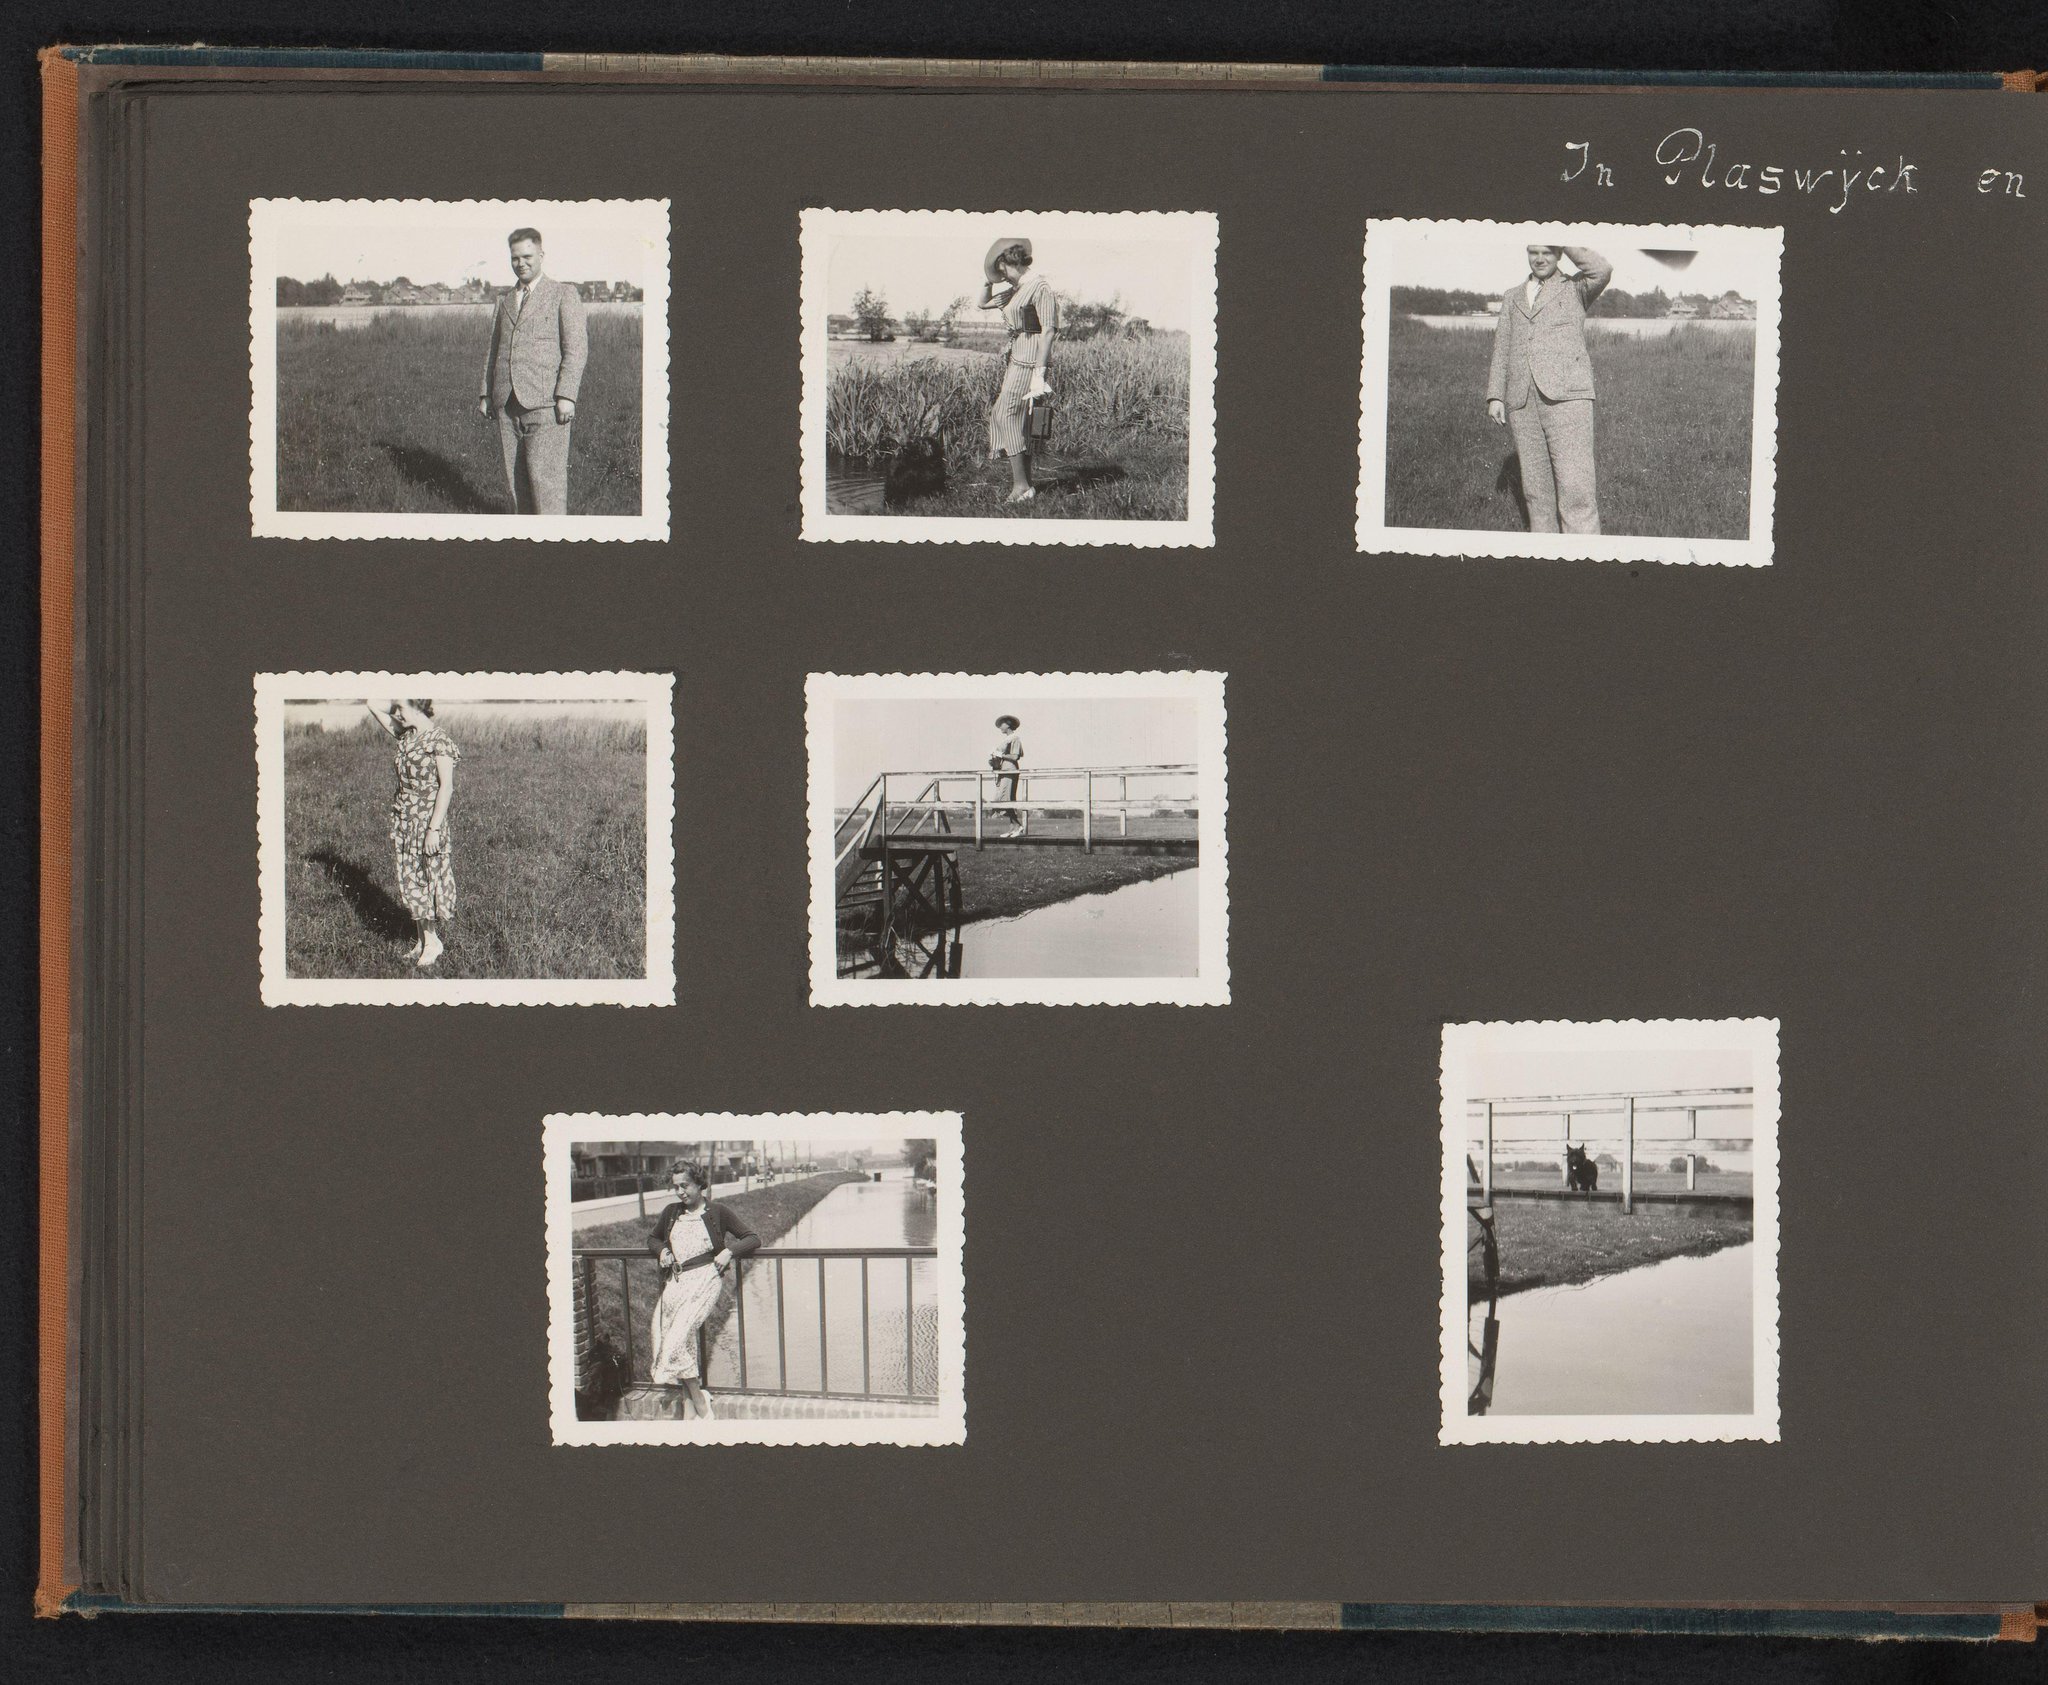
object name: photograph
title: Echtpaar Berti Hoppe en Herman Besselaar op stap in Plaswijck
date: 1906-1936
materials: cardboard, paper, photographic support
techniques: gelatin silver print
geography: rotterdam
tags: herman besselaar, berti hoppe, historical persons - bb - woman, historical persons, landscapes in the temperate zone (+ landscape with figures, staffage), landscape with bridge, viaduct or aqueduct (+ city(-scape) with figures, staffage), rotterdam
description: Zeven foto's gemaakt op een dag uit in juni 1936. Deze pagina maakt deel uit van een album.